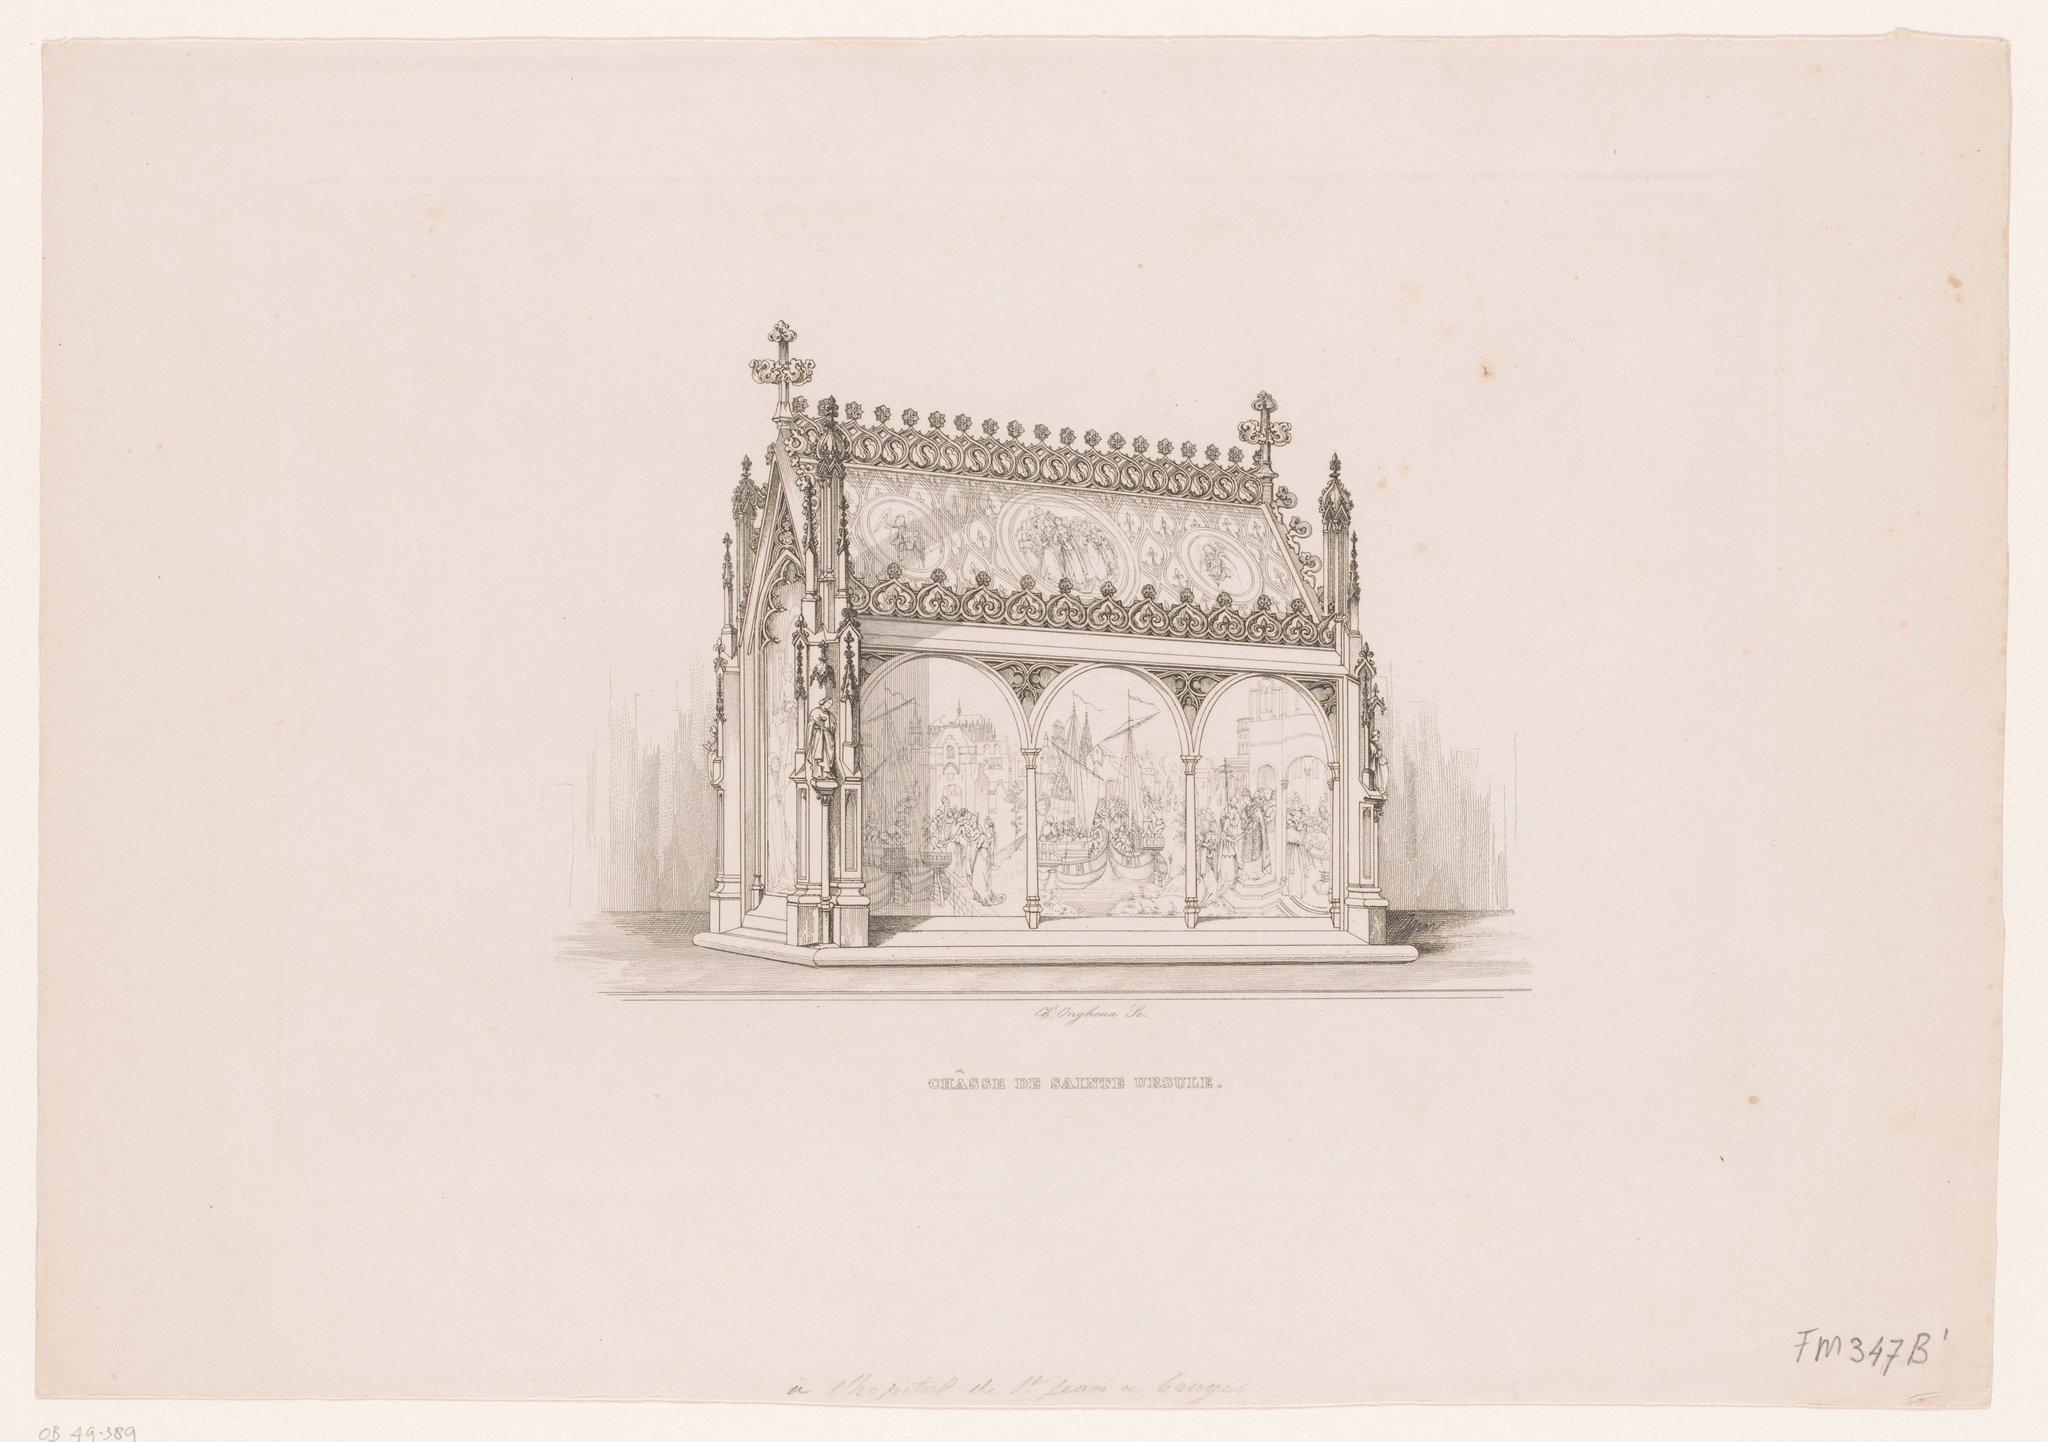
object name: print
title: Châsse van de H. Ursula in het Hospitaal van St. Jan te Brugge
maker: charles onghena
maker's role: print maker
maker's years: 1806-1886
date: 1841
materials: paper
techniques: etching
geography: brussels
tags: the virgin martyr ursula of cologne; possible attributes: arrow, banner with red cross, cloak of ermine, crown, ship, relics (and reliquaries)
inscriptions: collector's mark: Lugt 2228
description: Prent uit: Delepierre, Octave en Auguste Voisin. La Châsse de St. Ursule. Brussel: Société des Beaux-Arts, [1841].